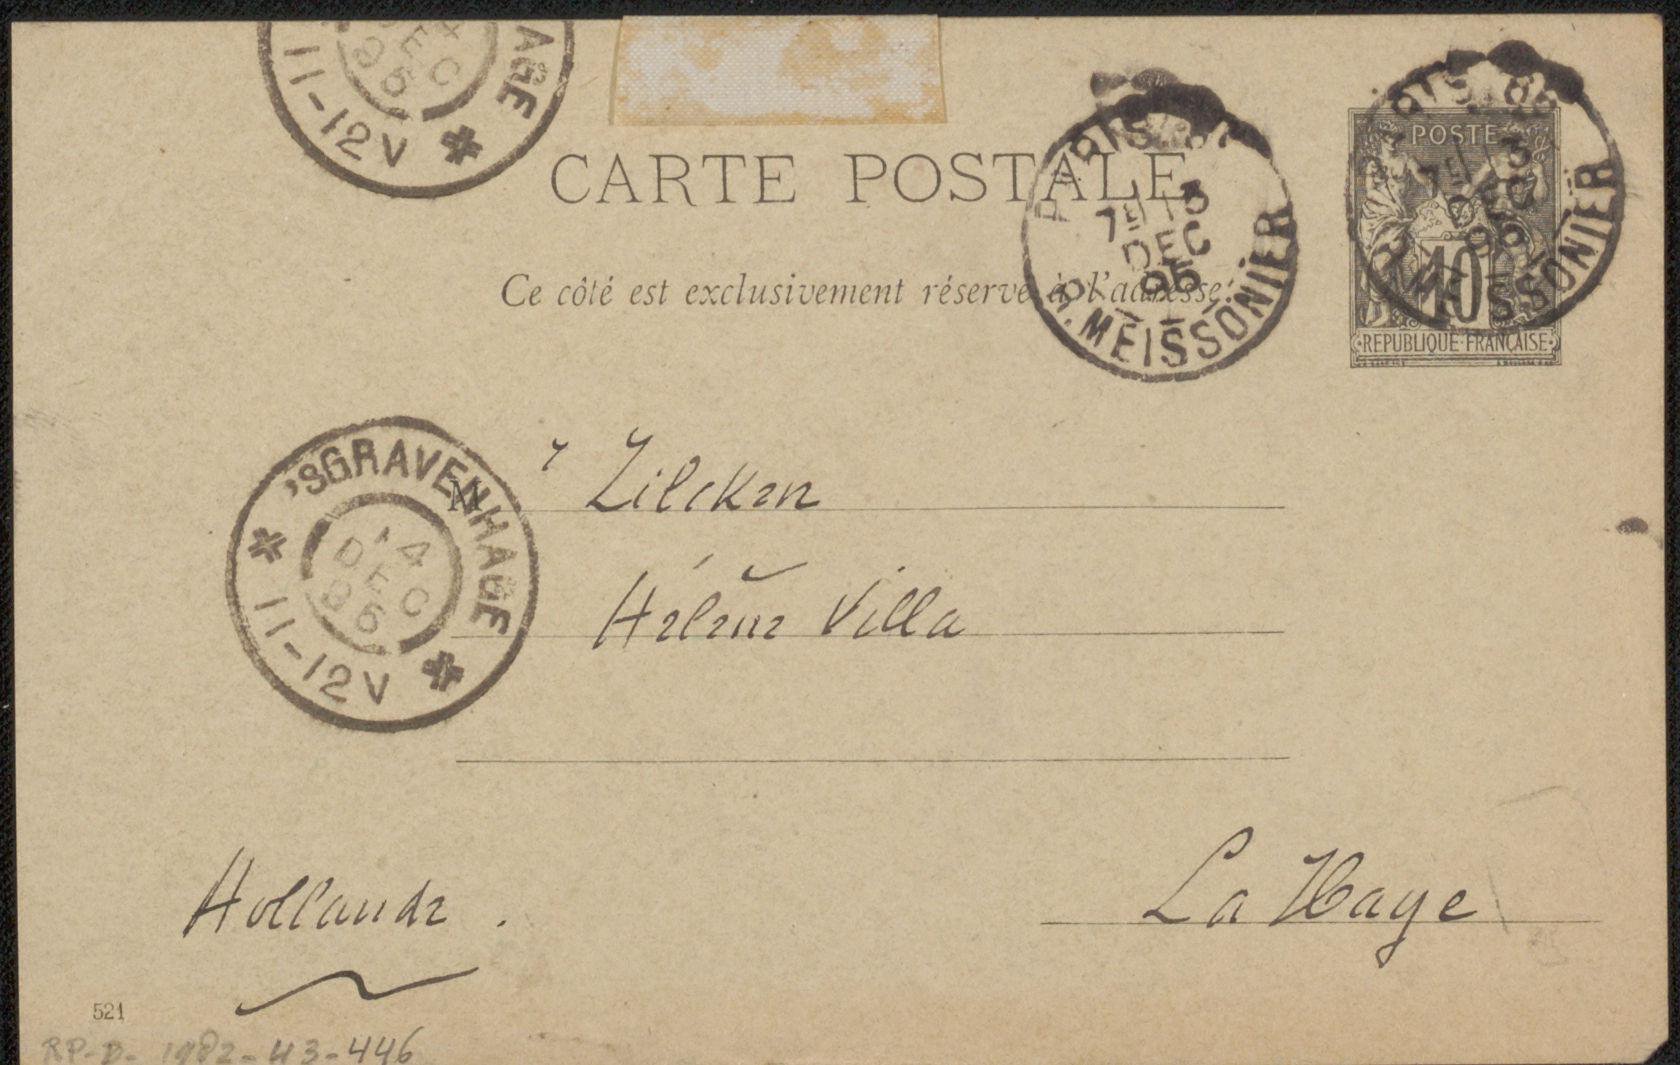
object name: postcard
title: Briefkaart aan Philip Zilcken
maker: georges rodenbach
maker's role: dichter, schrijver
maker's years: 1855-1898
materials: cardboard, ink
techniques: pen, writing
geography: paris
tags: brussels, helène lambertine hauzeur, the hague, painter, draughtsman, philip zilcken, passions, emotions, affections